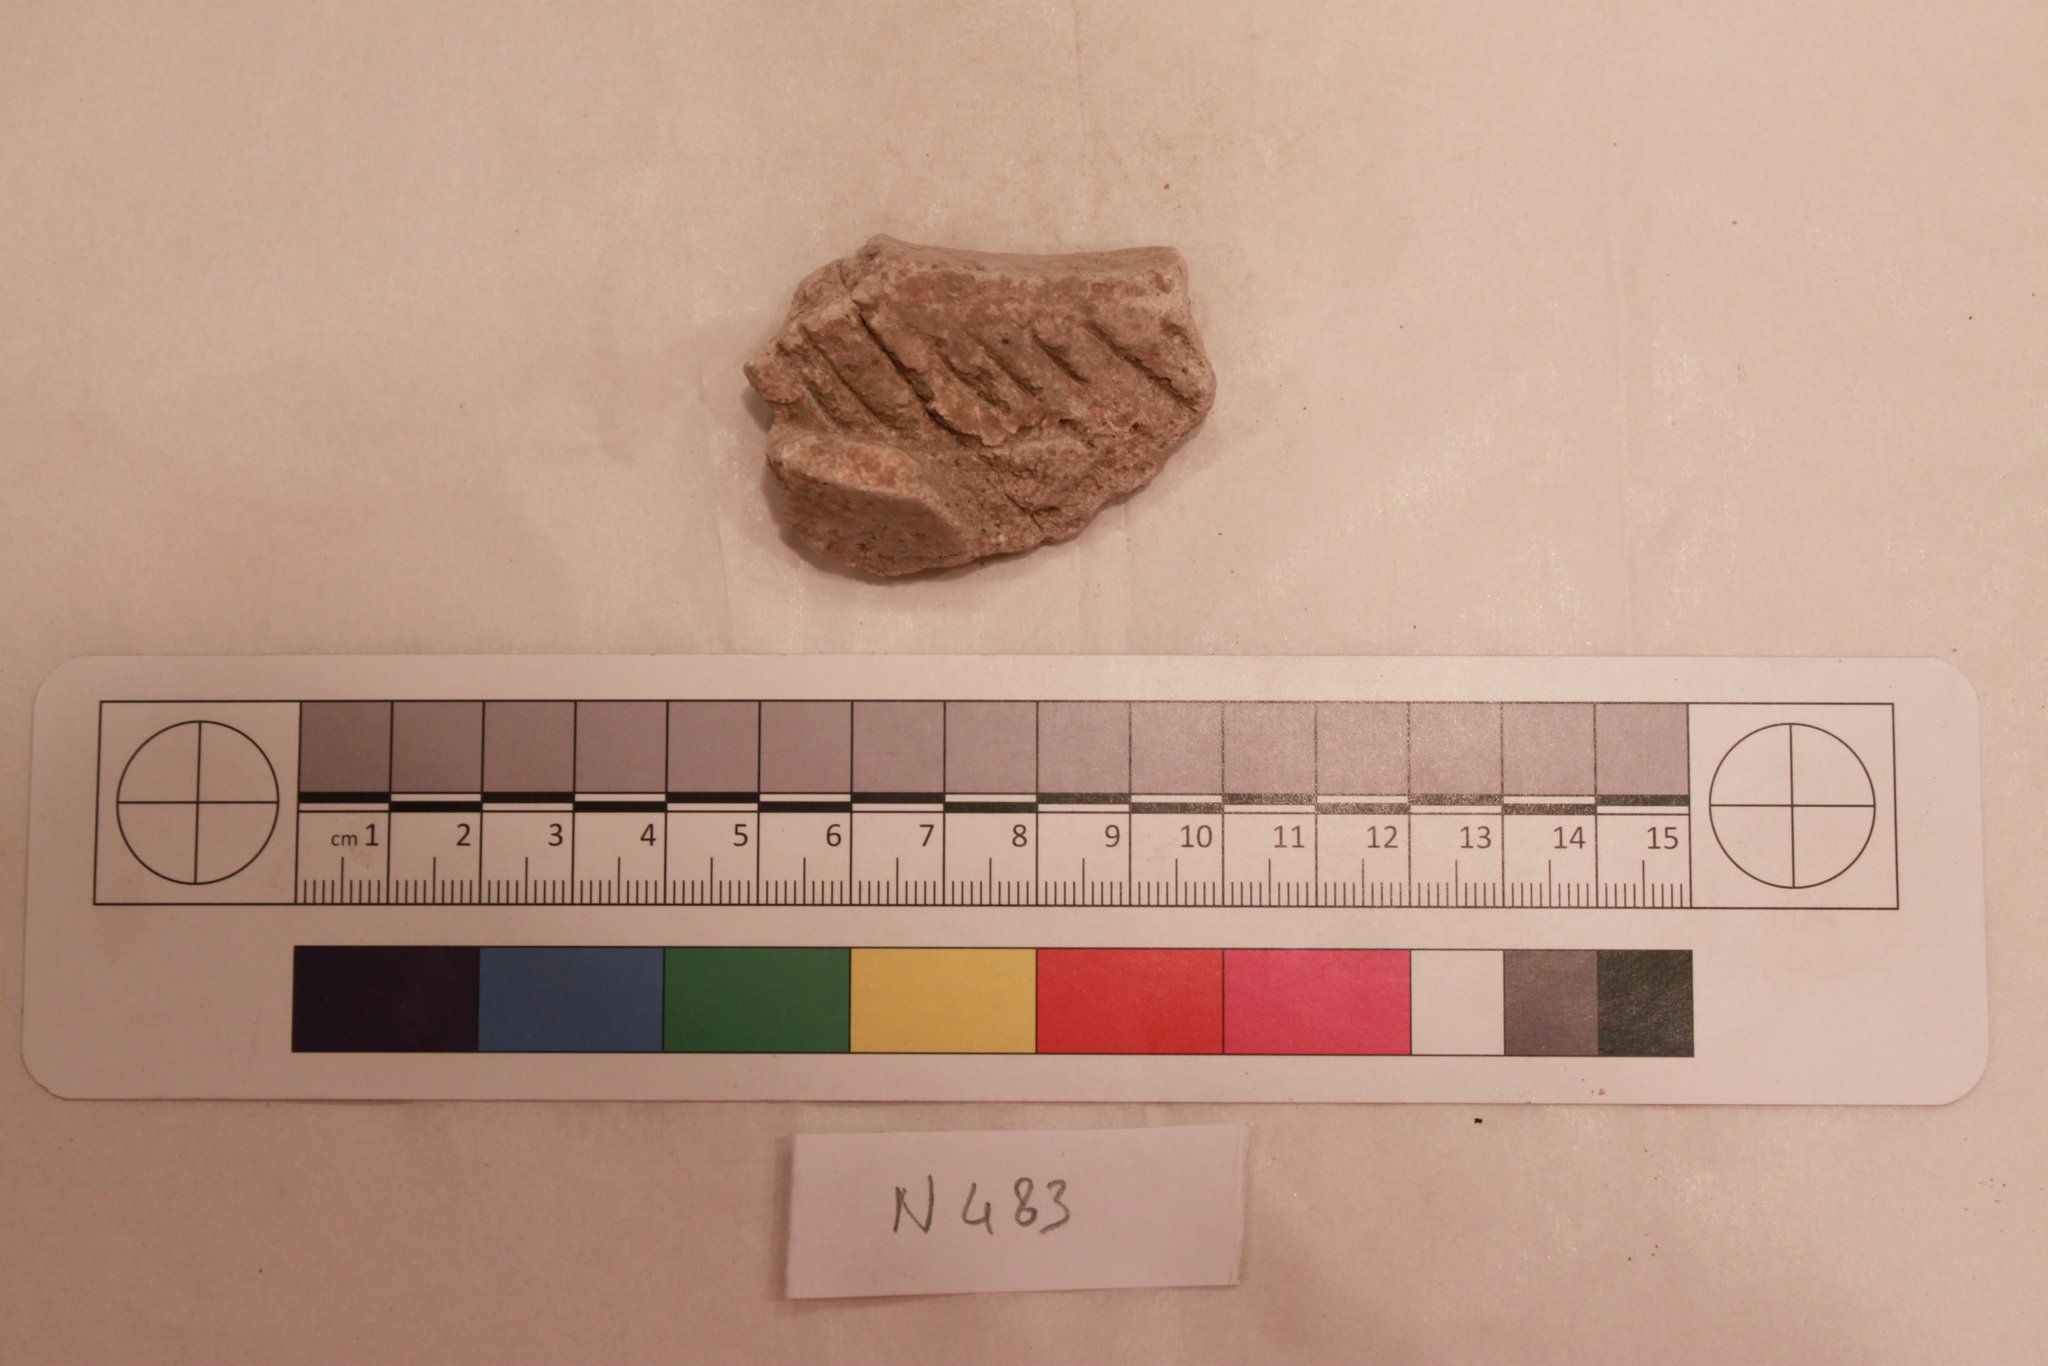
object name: fragment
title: Stucco Fragment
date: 701-1200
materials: plaster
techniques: carving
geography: iran